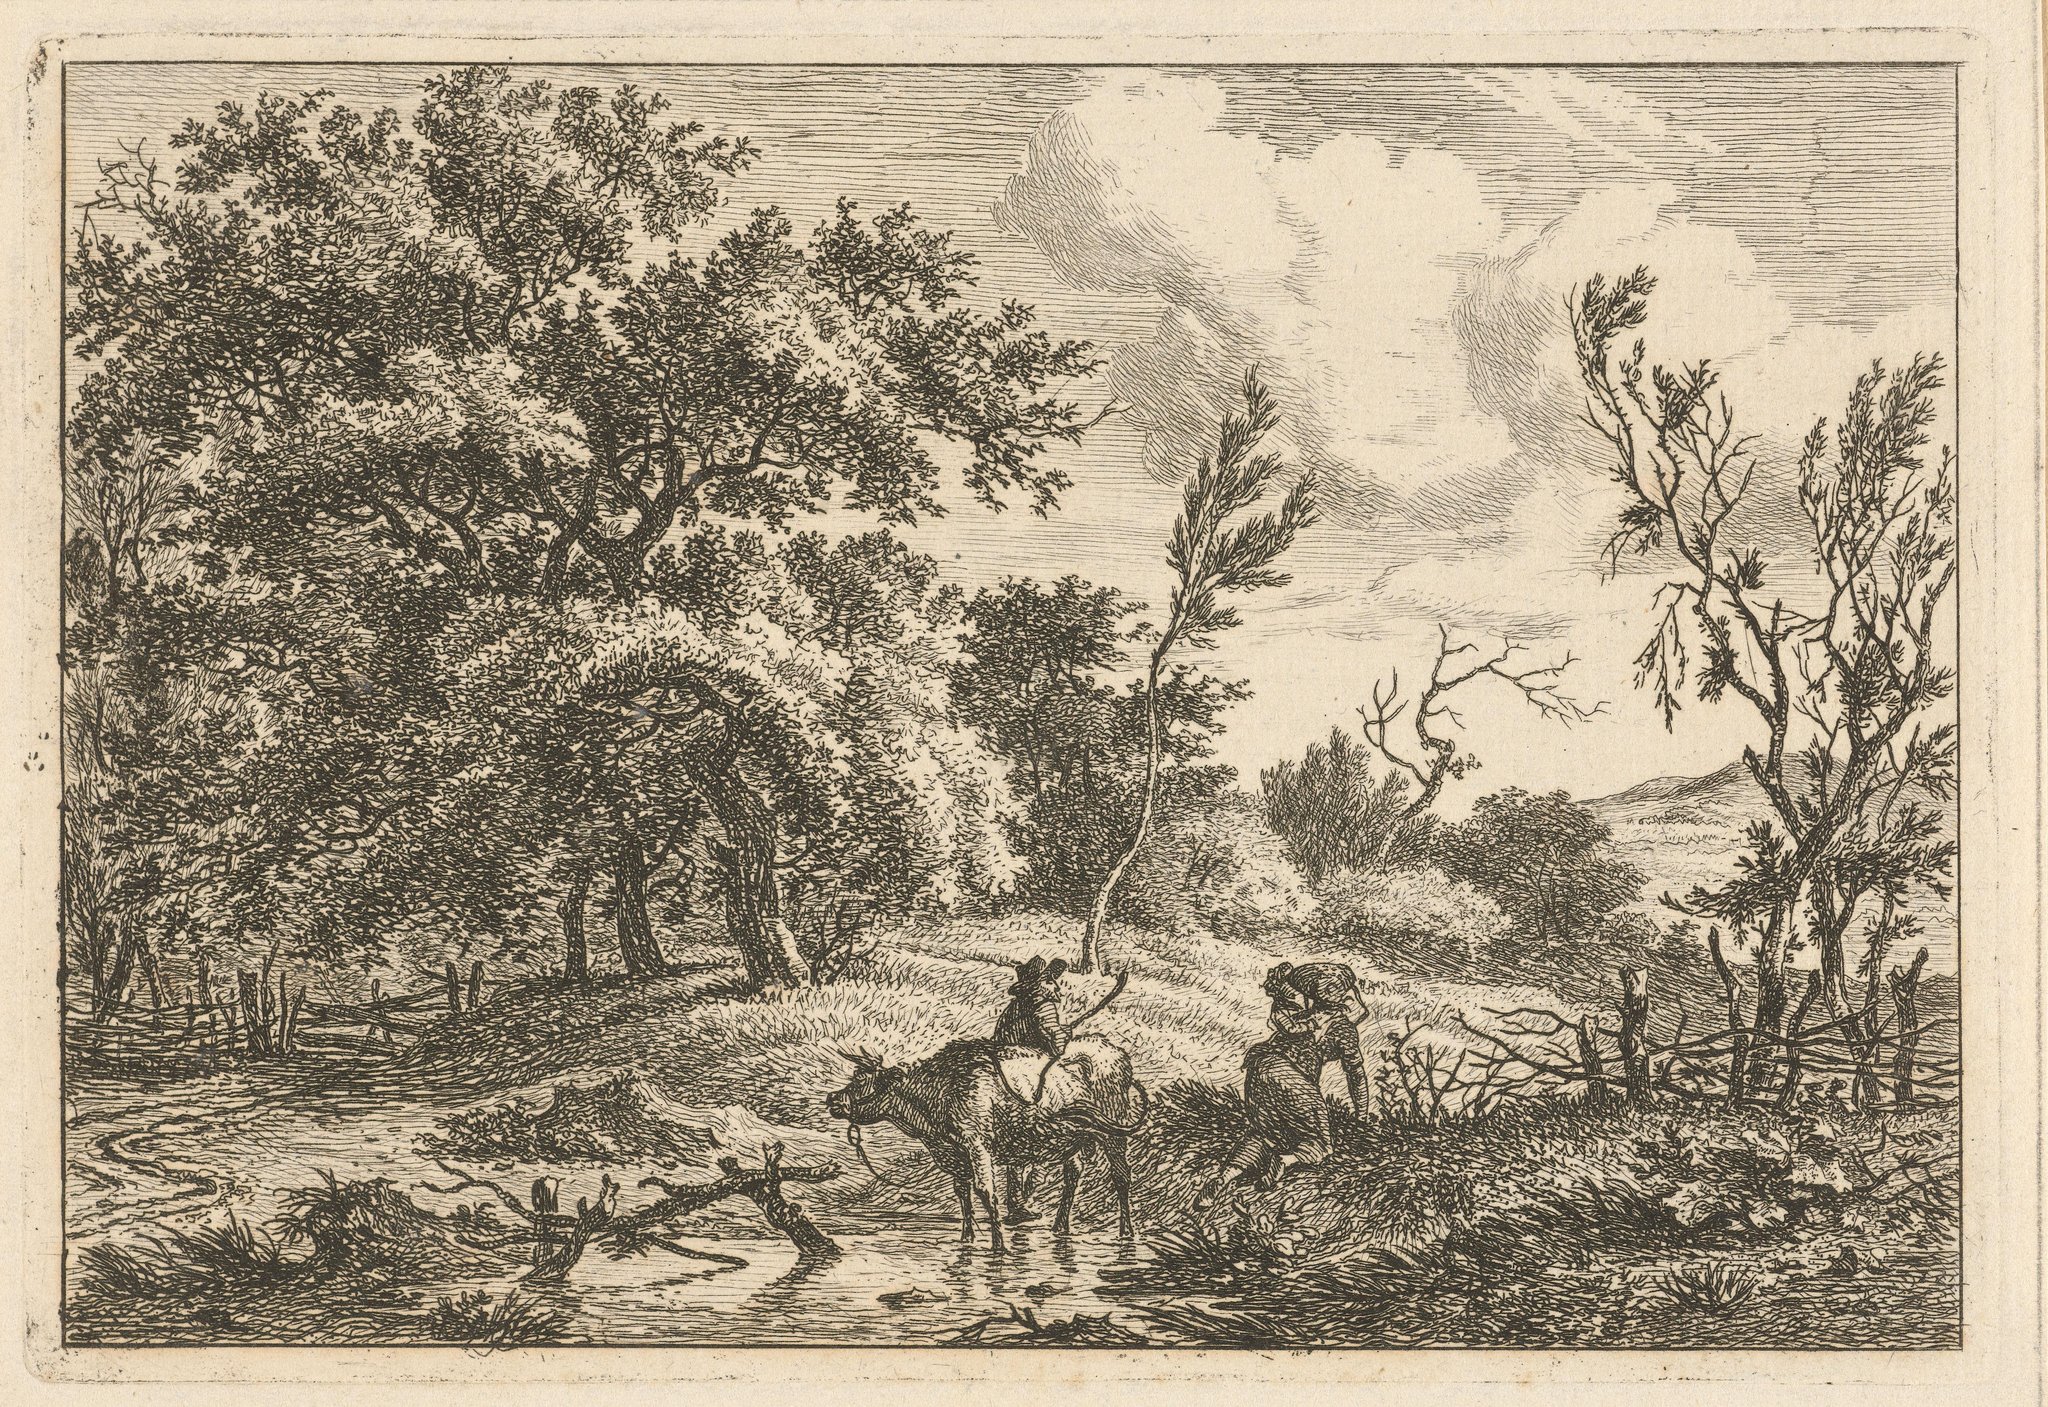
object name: print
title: Landschap met stier en veehoeder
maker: hermanus fock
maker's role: conservator, draughtsman, painter, print maker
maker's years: 1766-1822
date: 1781-1822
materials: paper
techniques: etching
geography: amsterdam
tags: bull, forest, wood (+ landscape with figures, staffage)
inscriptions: collector's mark: Lugt 2228, collector's mark: Lugt 924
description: In een glooiend landschap staat een stier in ondiep water. Achter de stier staat een veehoeder en in het gras zitten een man en een vrouw. Op de achtergrond leidt een slingerend pad het bos in.